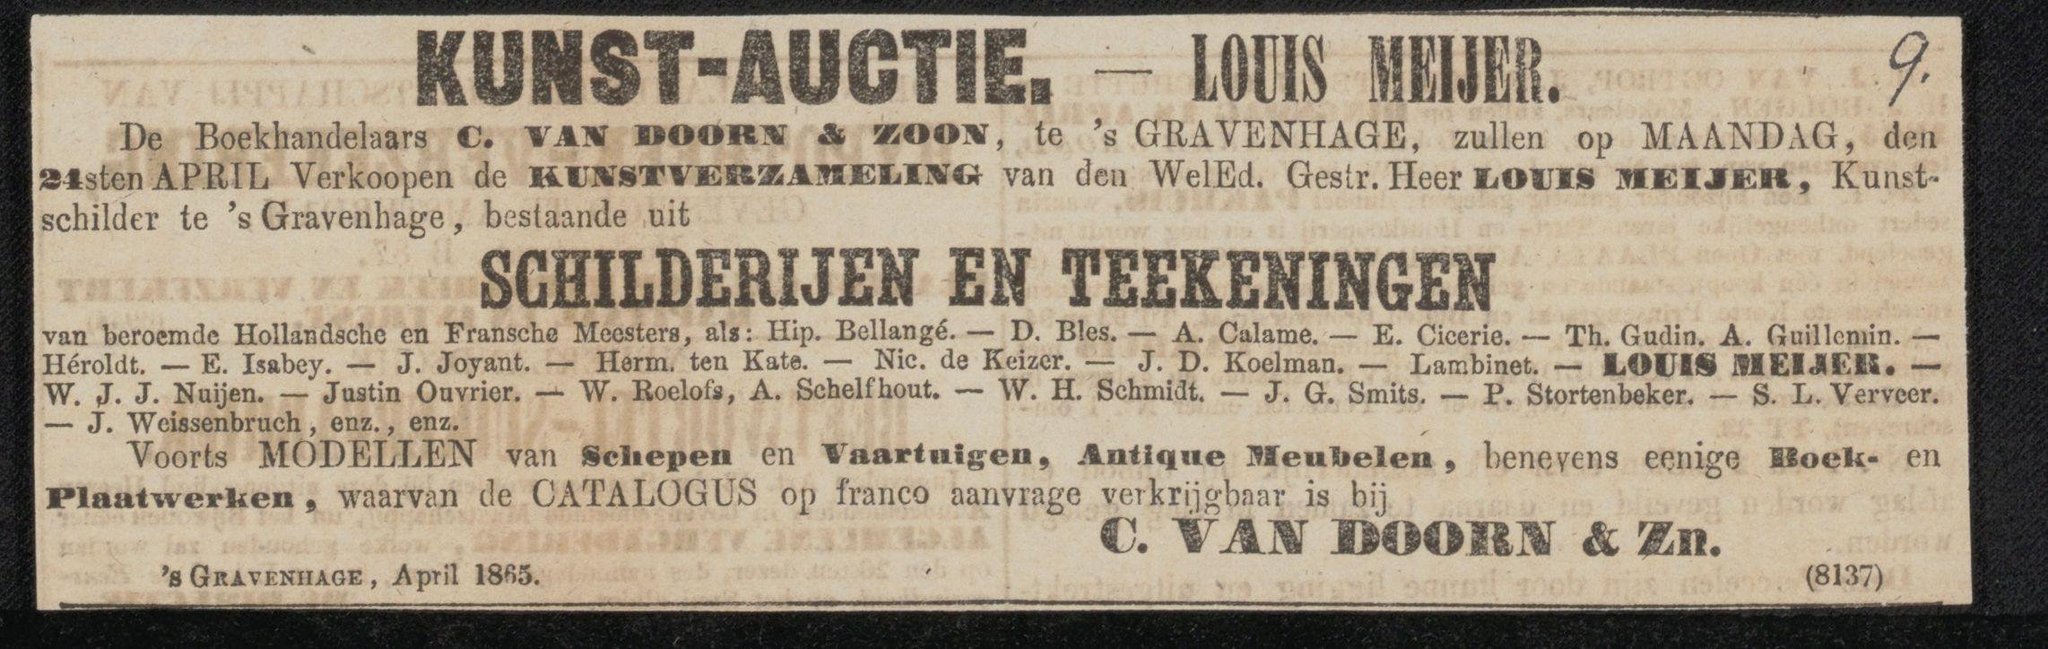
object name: newspaper clipping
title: Krantenknipsel betreffende Louis Meijer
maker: Anonymous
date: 1865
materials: paper, ink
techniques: printing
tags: amsterdam, utrecht, painter, print maker, draughtsman, louis meijer